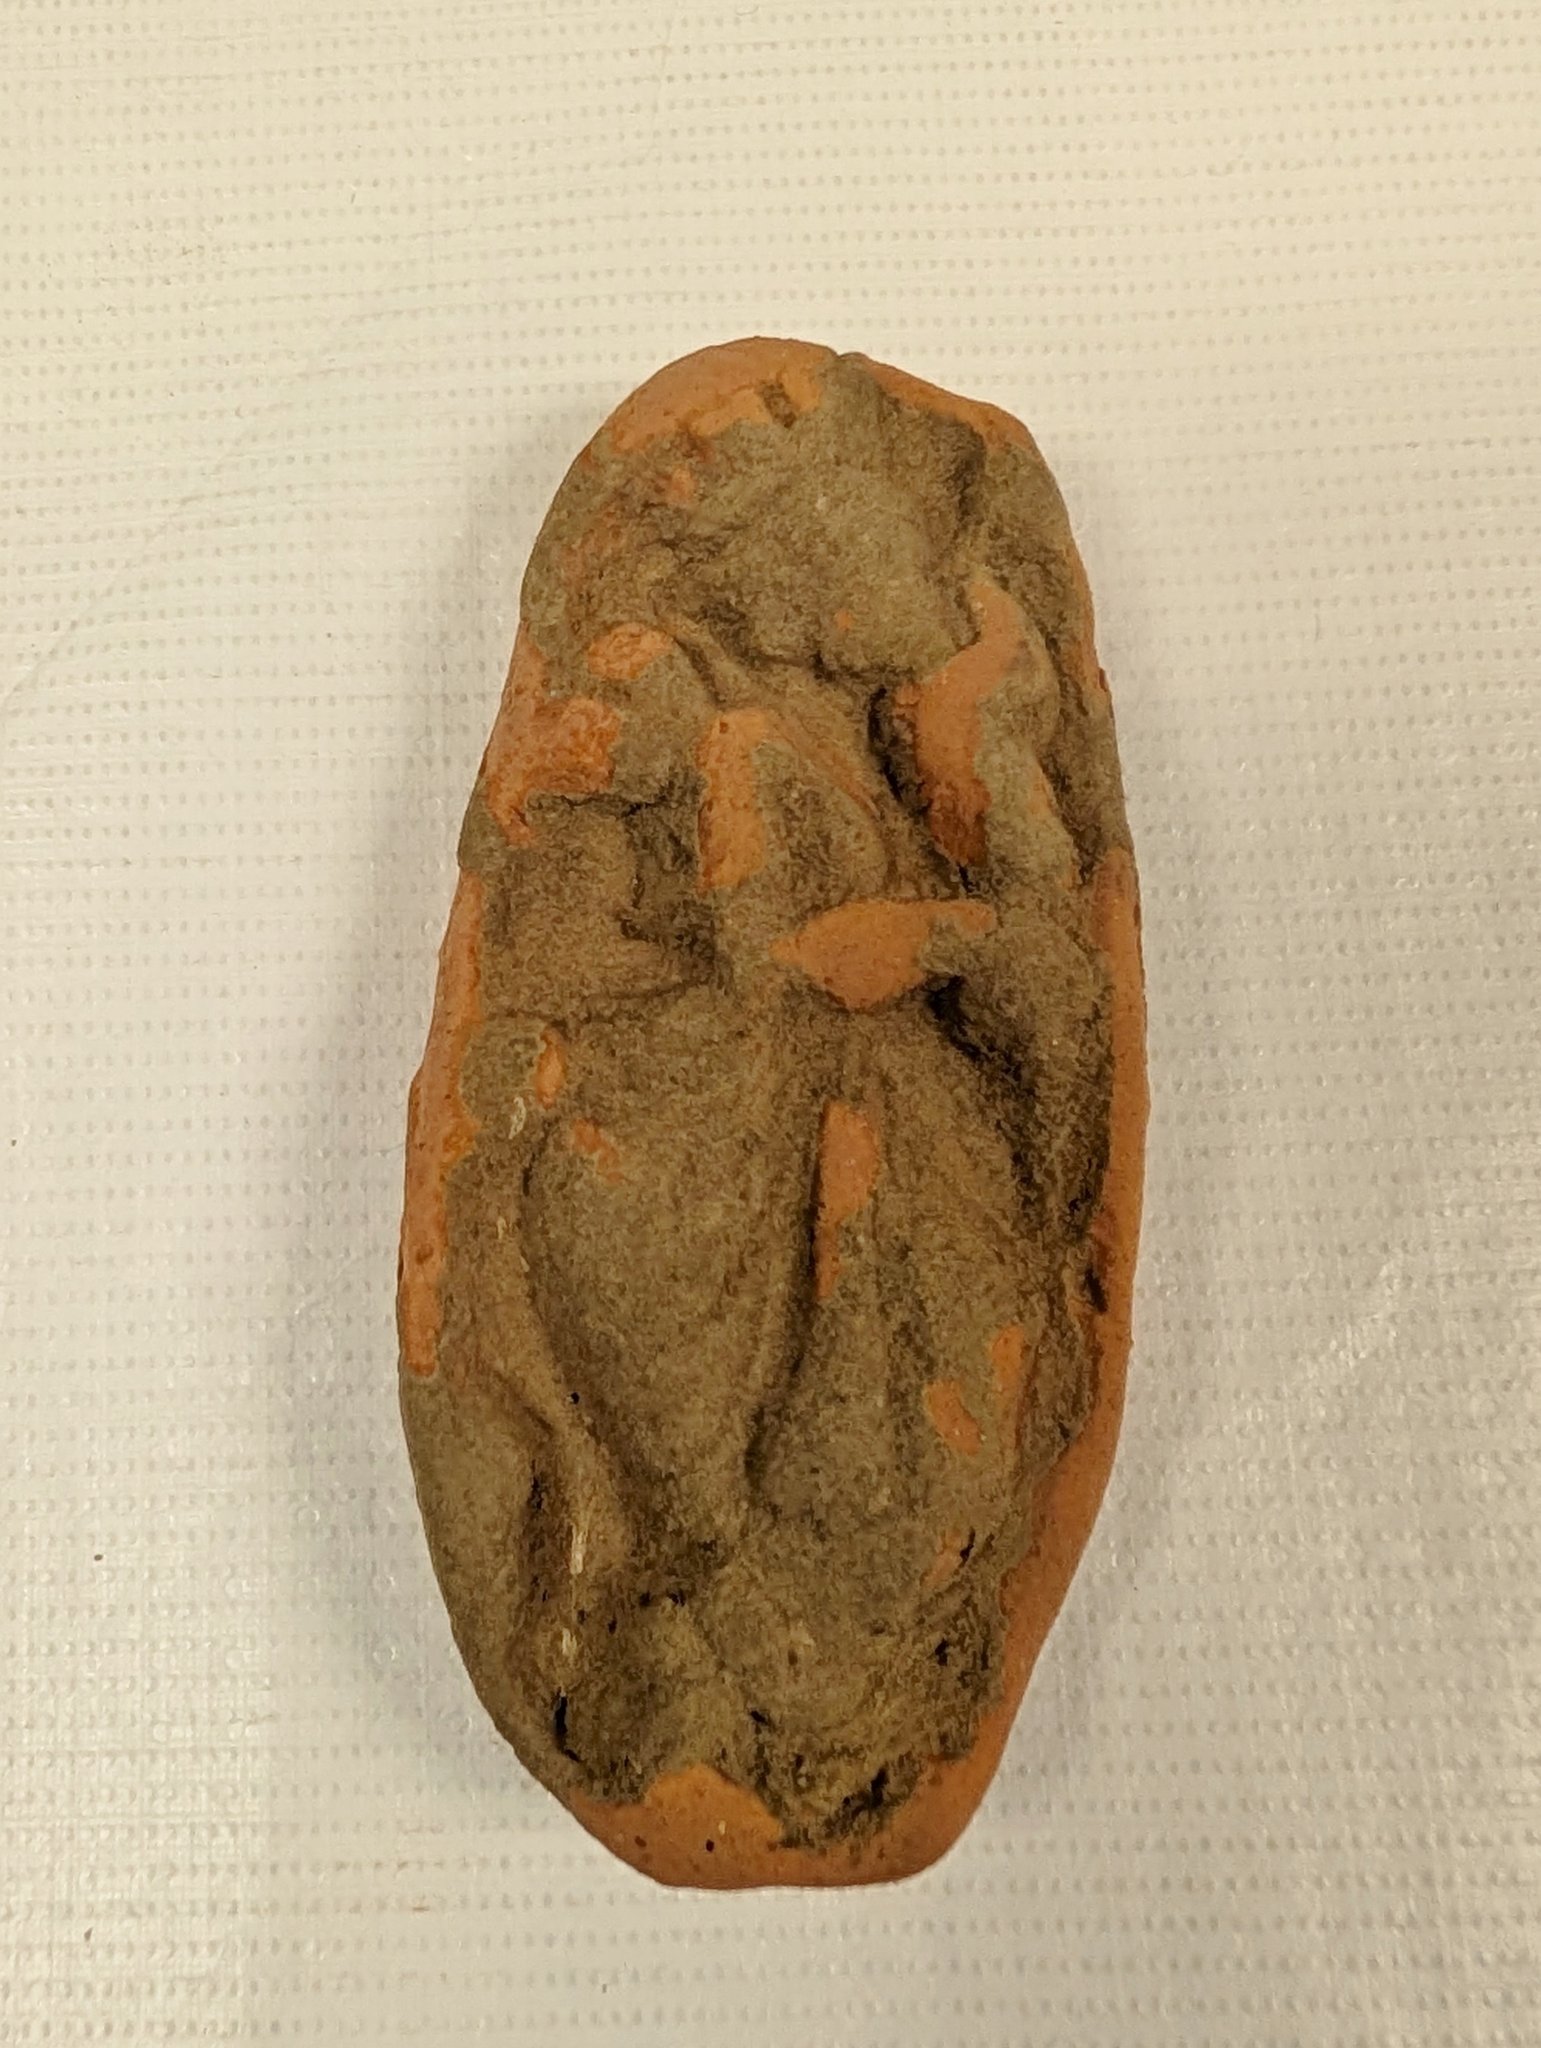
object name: plaque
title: Plaque in the Form of a Female Figure (Study Collction)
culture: pakistani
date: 101-300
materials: terracotta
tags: gandhara